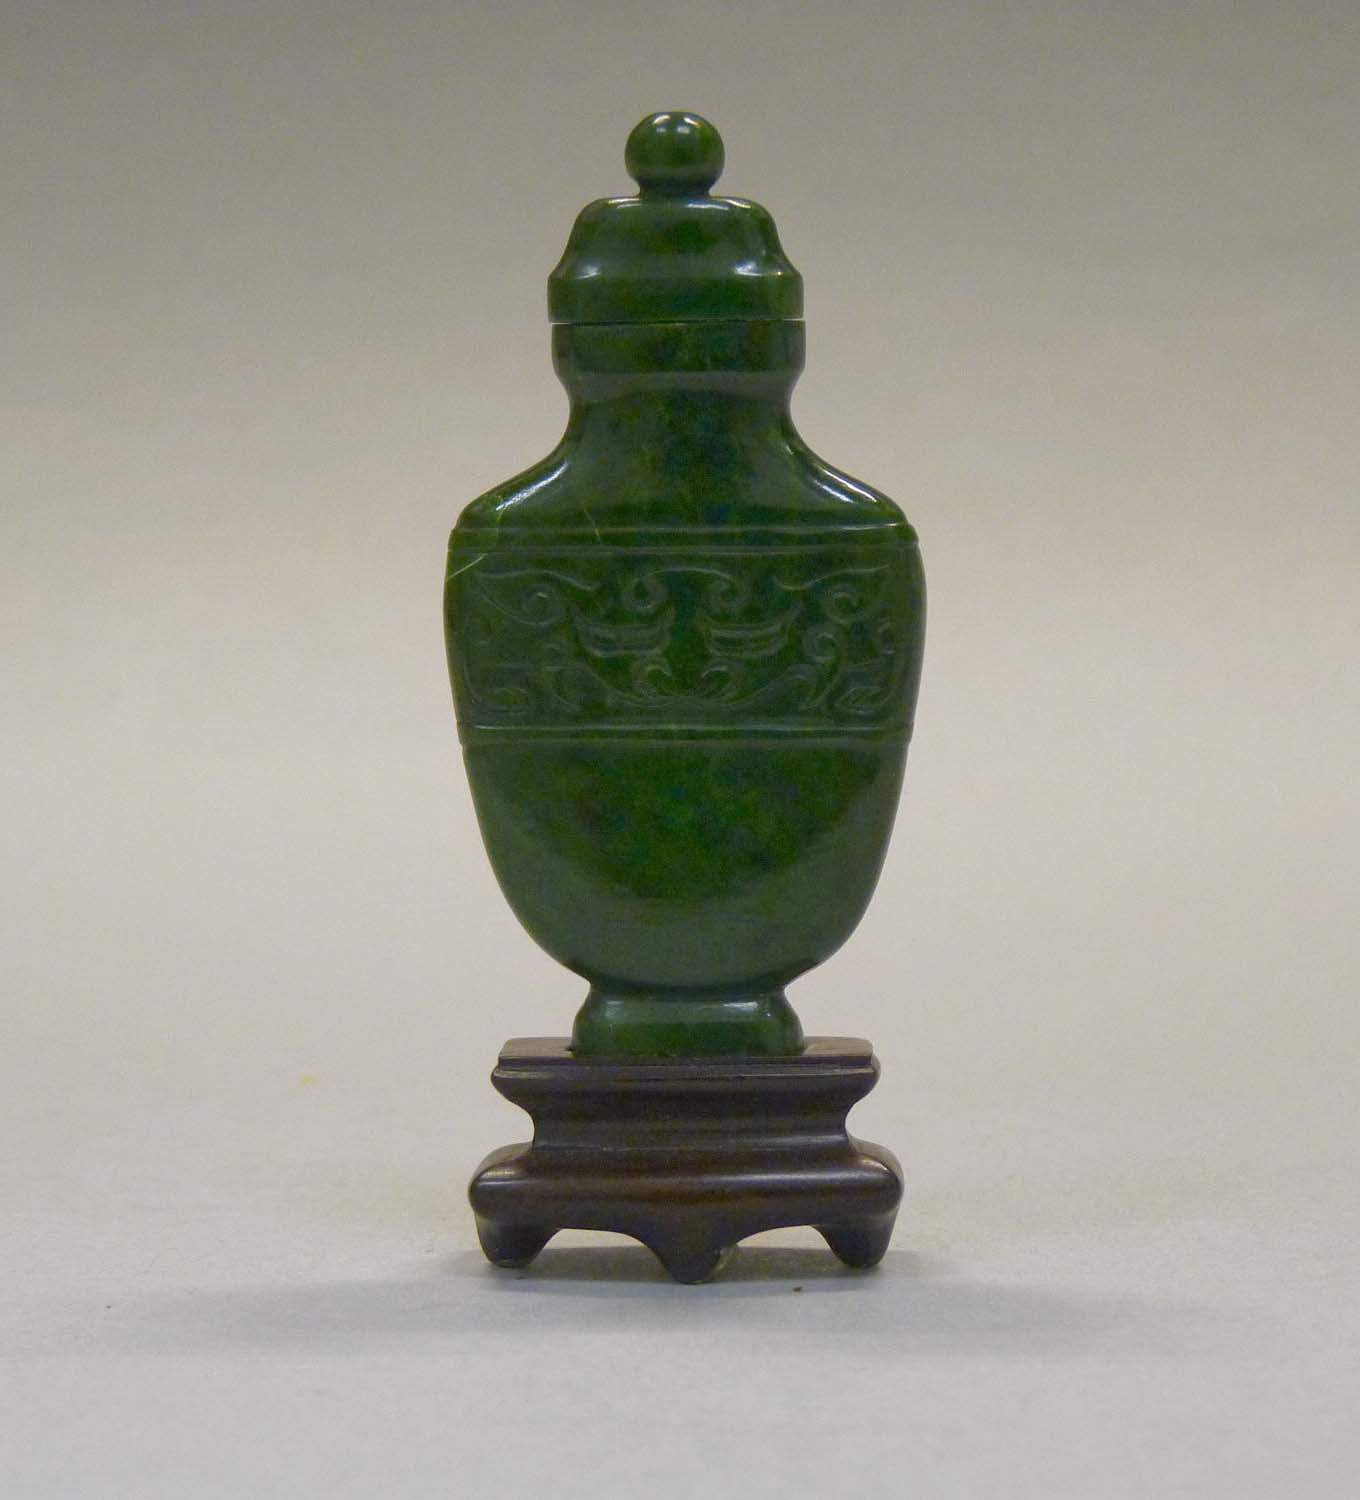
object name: snuff bottle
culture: chinese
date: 1736-1795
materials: jade, wood